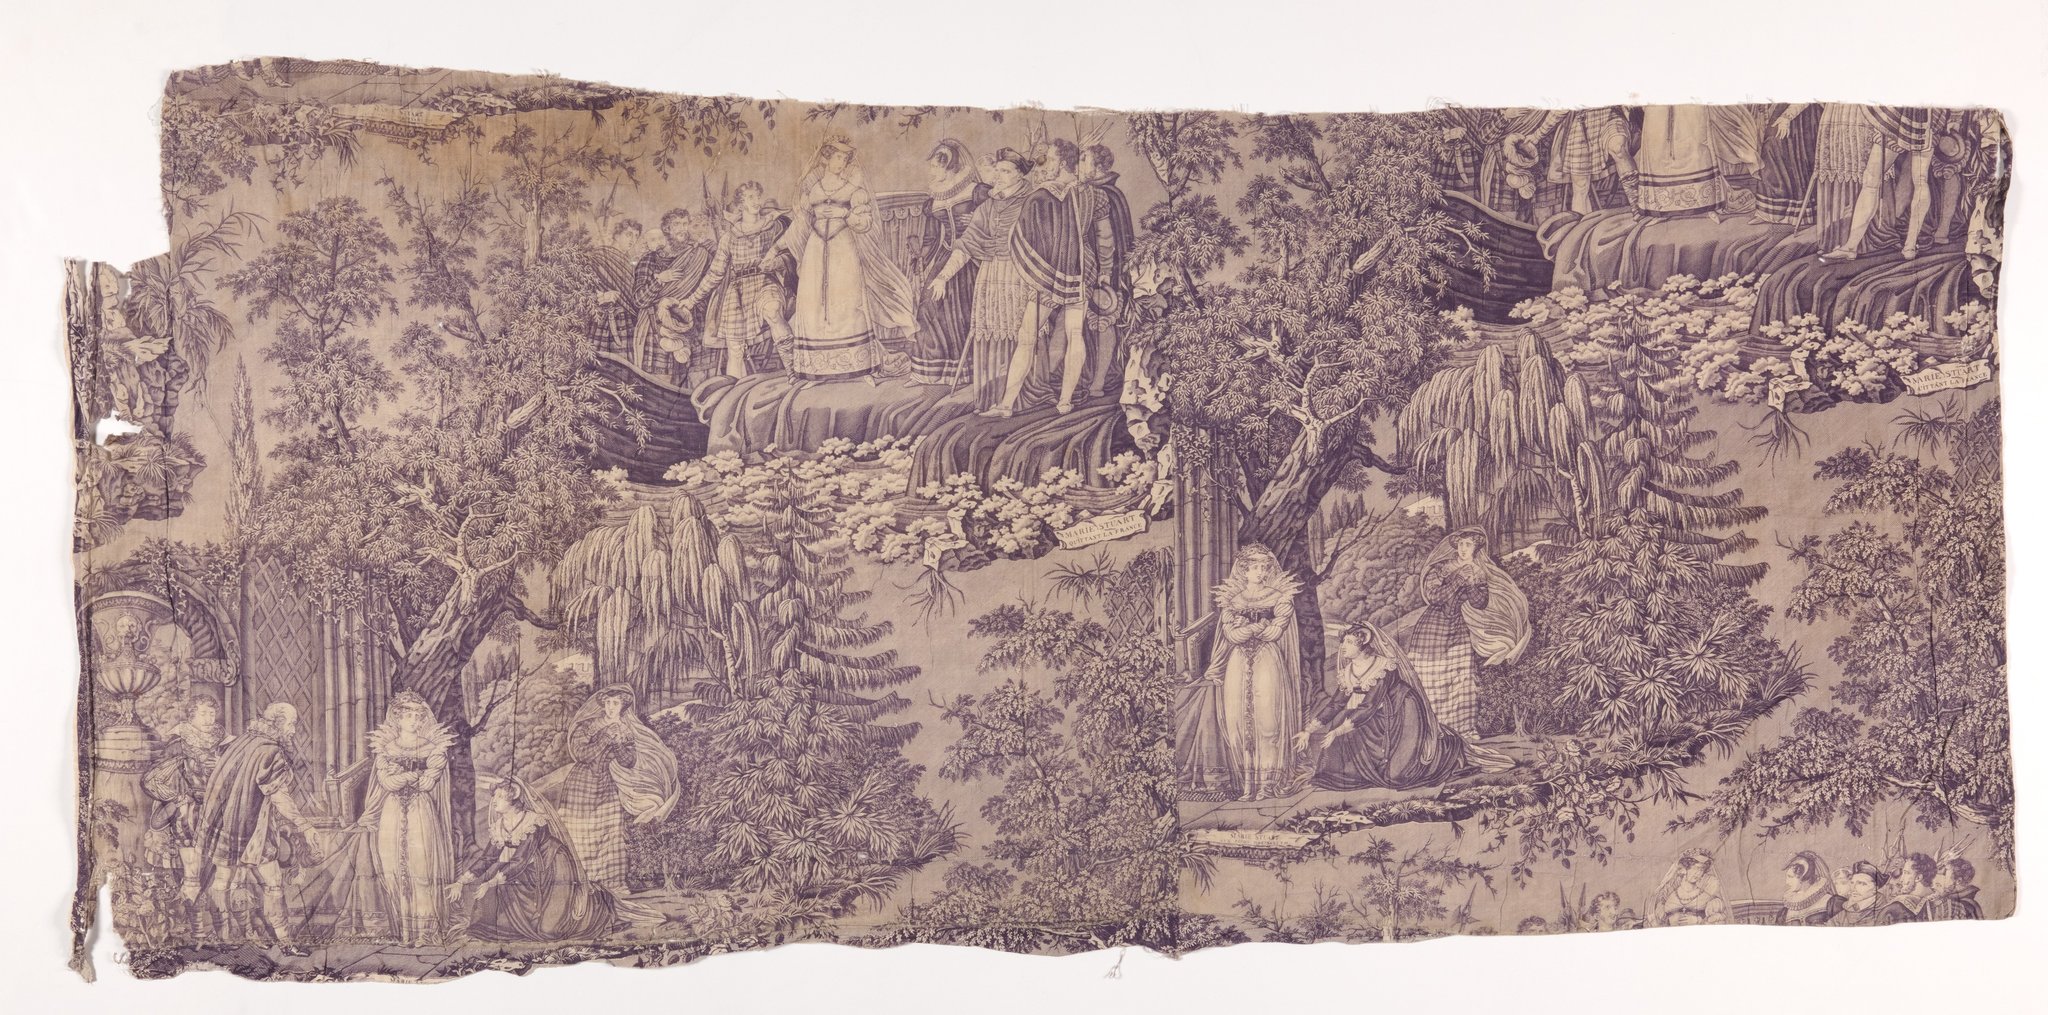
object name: length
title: Scenes from the life of Mary Queen of Scots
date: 1820-1829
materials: cotton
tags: queens,men,women,trees